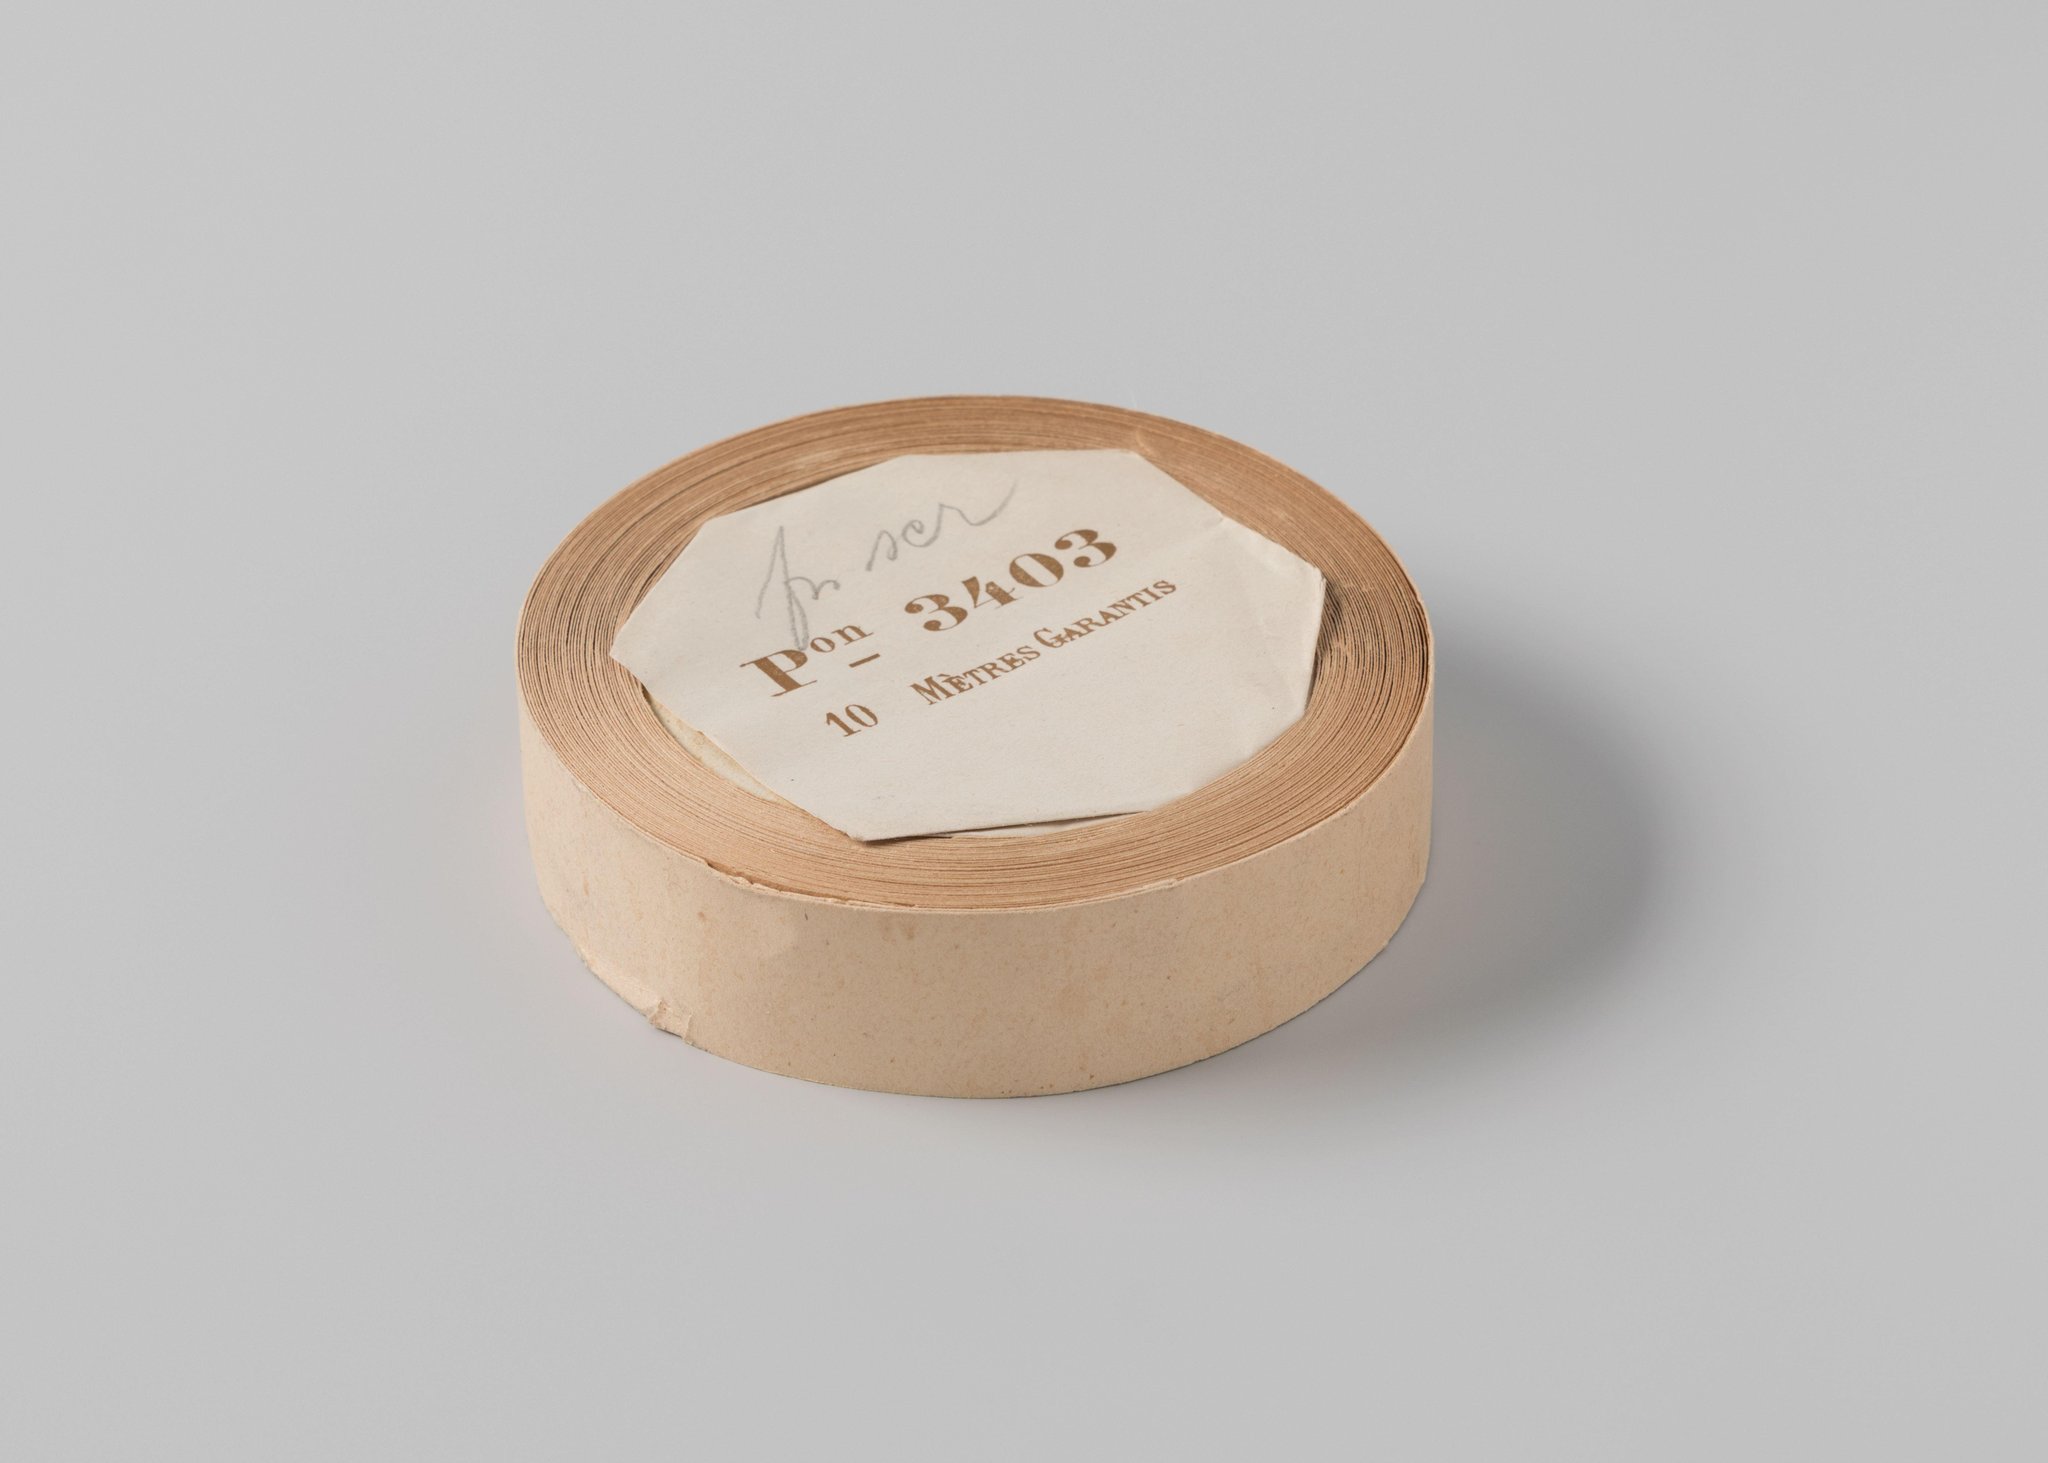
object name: braid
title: Rol met wit lint met één gerafelde zijde en drie zwarte horizontale strepen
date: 1930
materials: cardboard, paper, textile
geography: france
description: Rol met wit lint met één gerafelde zijde en drie zwarte horizontale strepen.